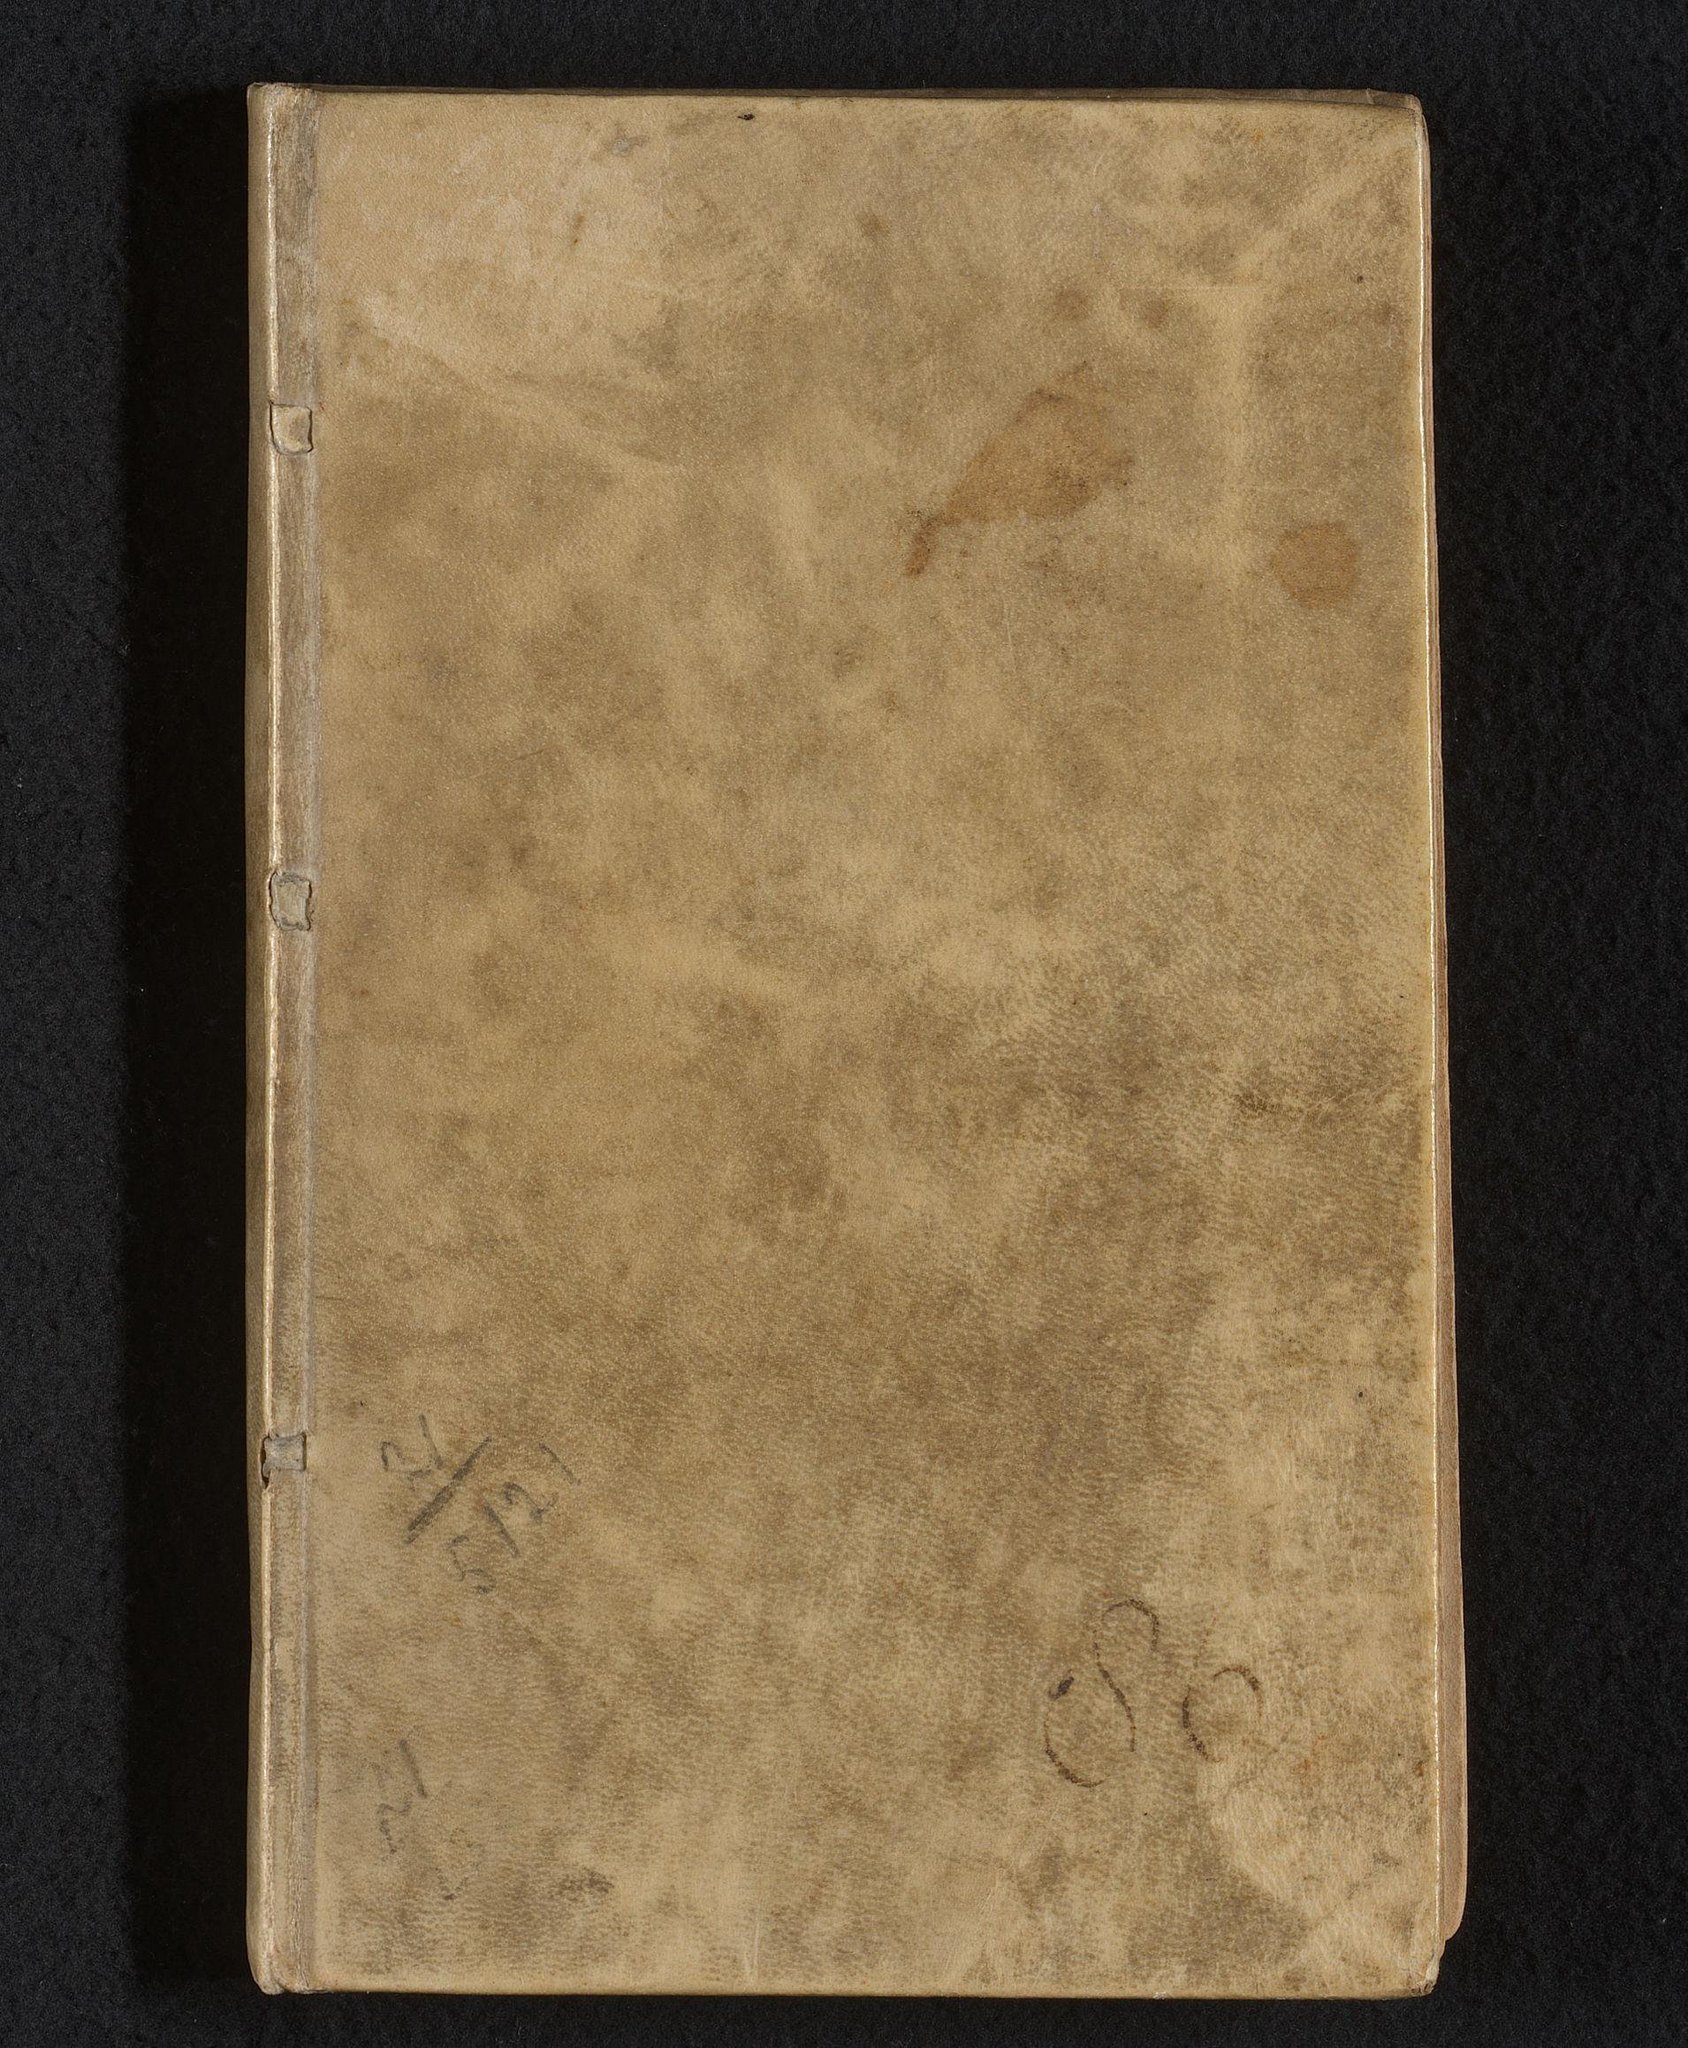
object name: sketchbook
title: Schetsboek met 92 bladen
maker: johann goll van frankenstein (i)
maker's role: amateurtekenaar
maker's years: 1722-1785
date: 1760-1785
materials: ink, paper, parchment, pencil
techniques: pen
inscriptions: inscription: ‘86’, inscription: ‘21/5121/ 21/23’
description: Inhoud: boomstudies, studies van een koets, maaiers, een vrouw met mand, gezicht op IJ, omgeving Amsterdam, kade met trekschuit, gezichten op/bij de Amstel, watermolen buiten de Haarlemmerpoort, in het Gein, Weesp, Weespervaart, de vaart van Weesp naar Amsterdam, Haarlemmerhout.